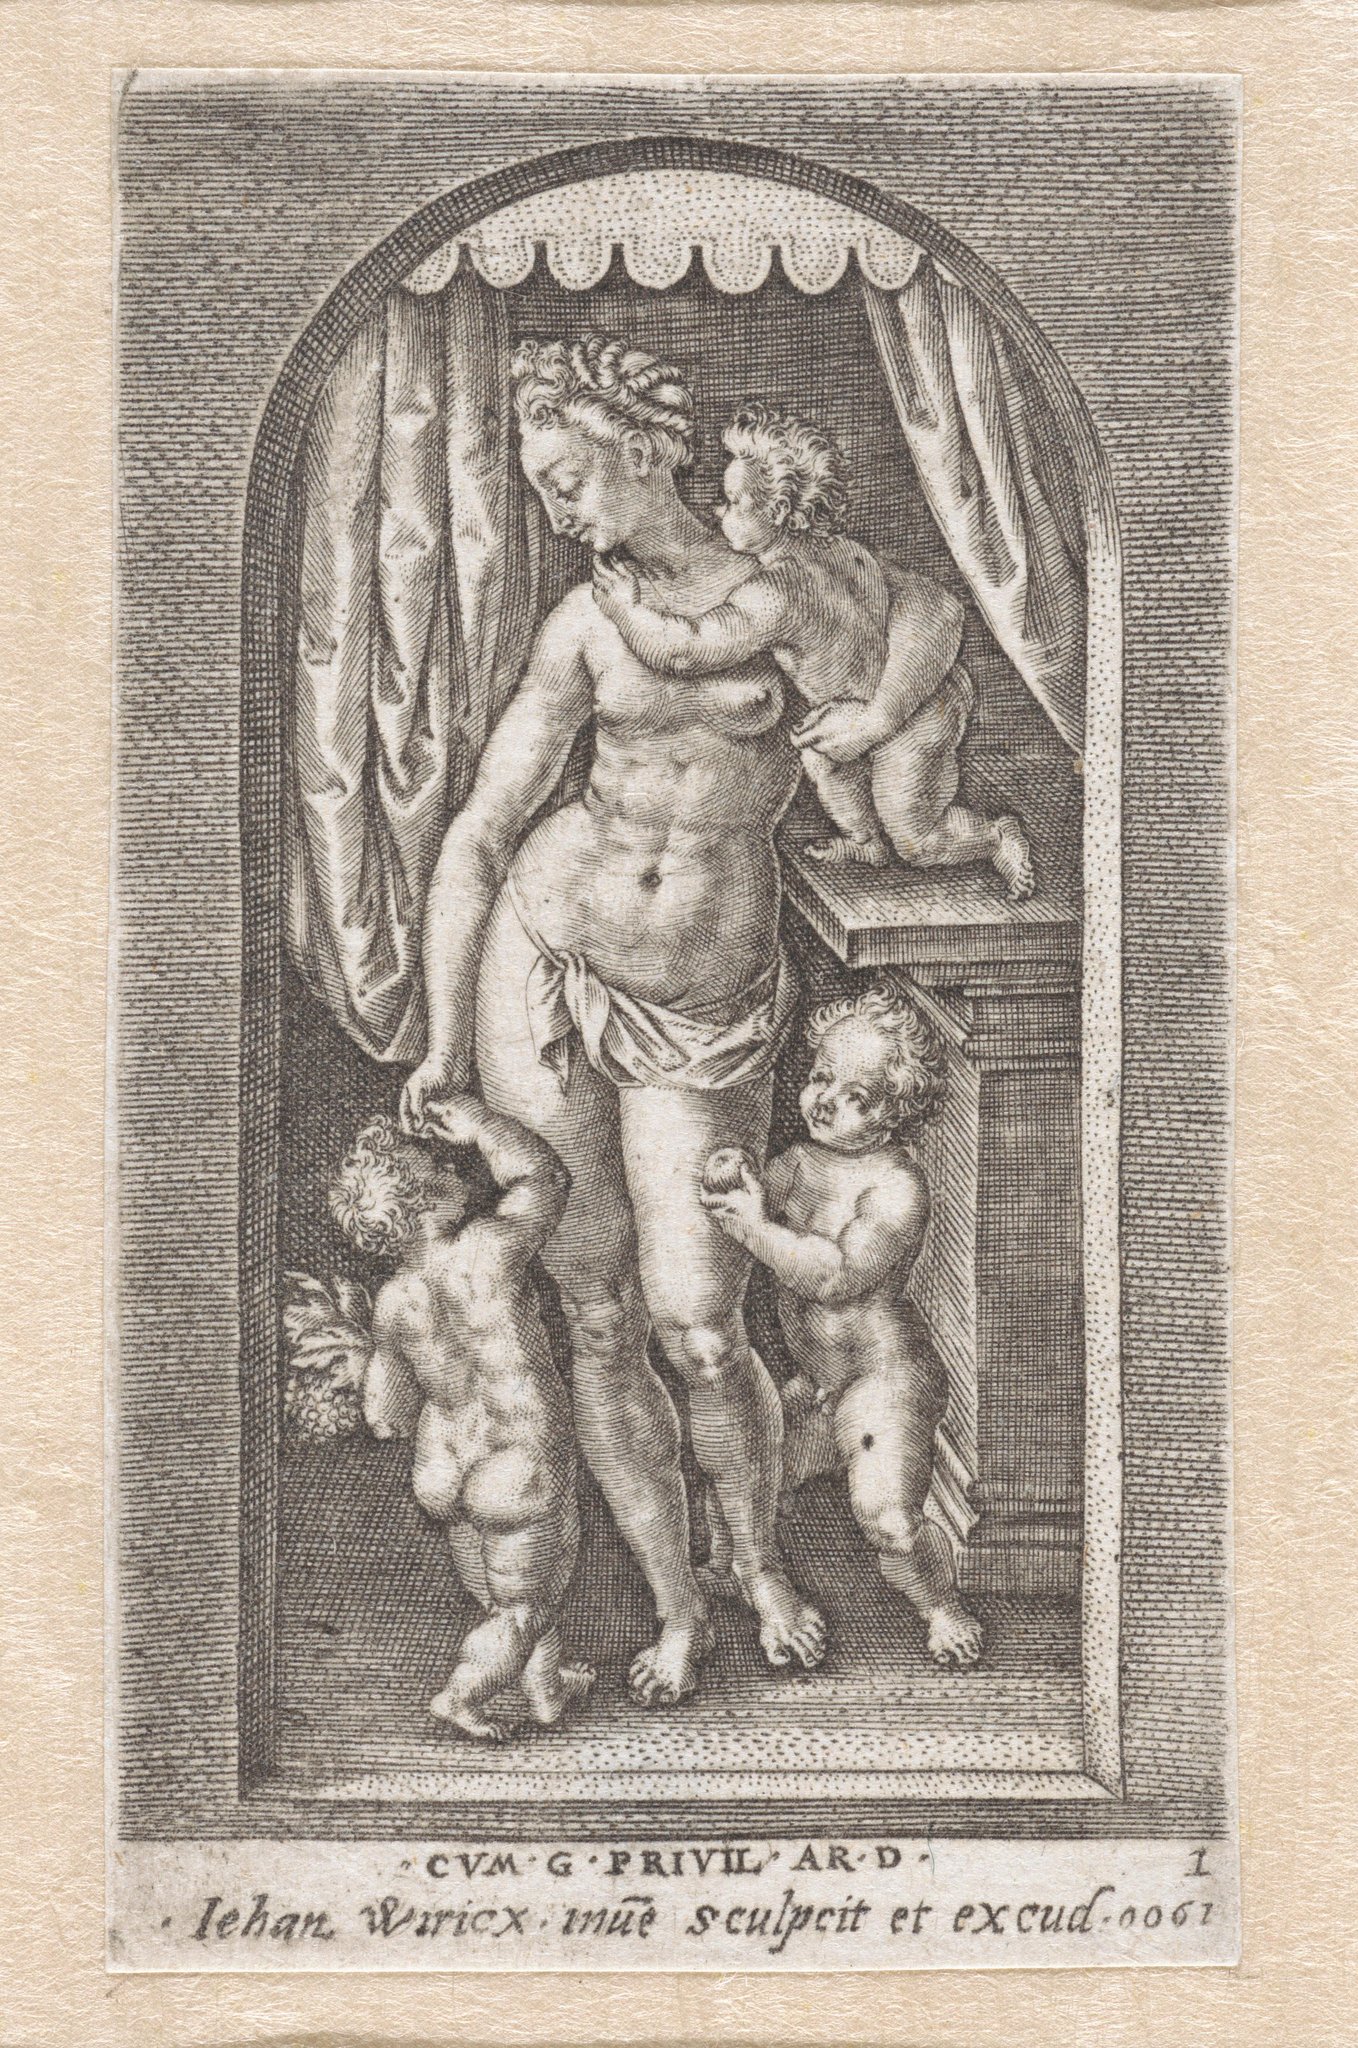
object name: print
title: Voorbeelden van liefde en lust door Venus gepersonifieerd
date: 1600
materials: paper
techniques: engraving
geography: antwerp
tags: charity, 'caritas'; 'carità' (ripa) ~ one of the three theological virtues, specific aspects, allegorical aspects of venus; venus as patroness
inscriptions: collector's mark: Lugt 2228, collector's mark: Lugt 2760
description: Venus als personificatie van de Liefde (zowel de liefde tot God als de naastenliefde). Ze staat in een nis, één kind in de armen, twee kinderen aan haar voeten.